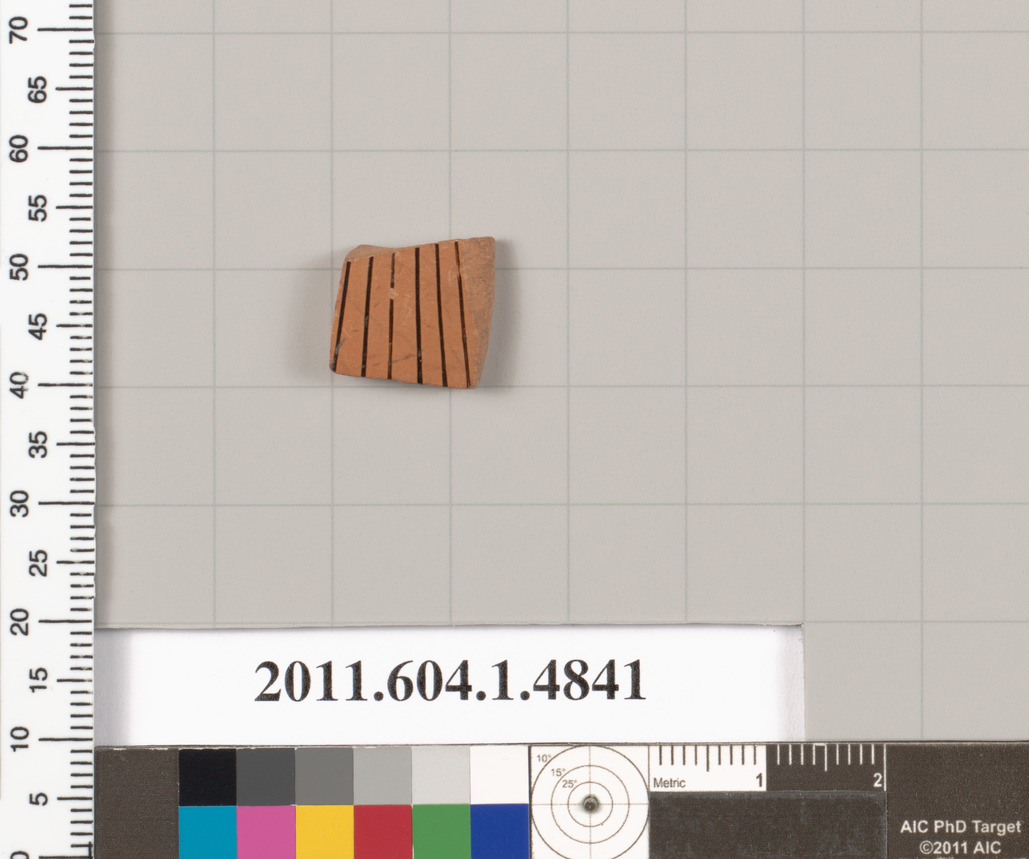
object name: kylix fragment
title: Terracotta fragment of a kylix (drinking cup)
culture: greek, attic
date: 490-480 BCE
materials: terracotta